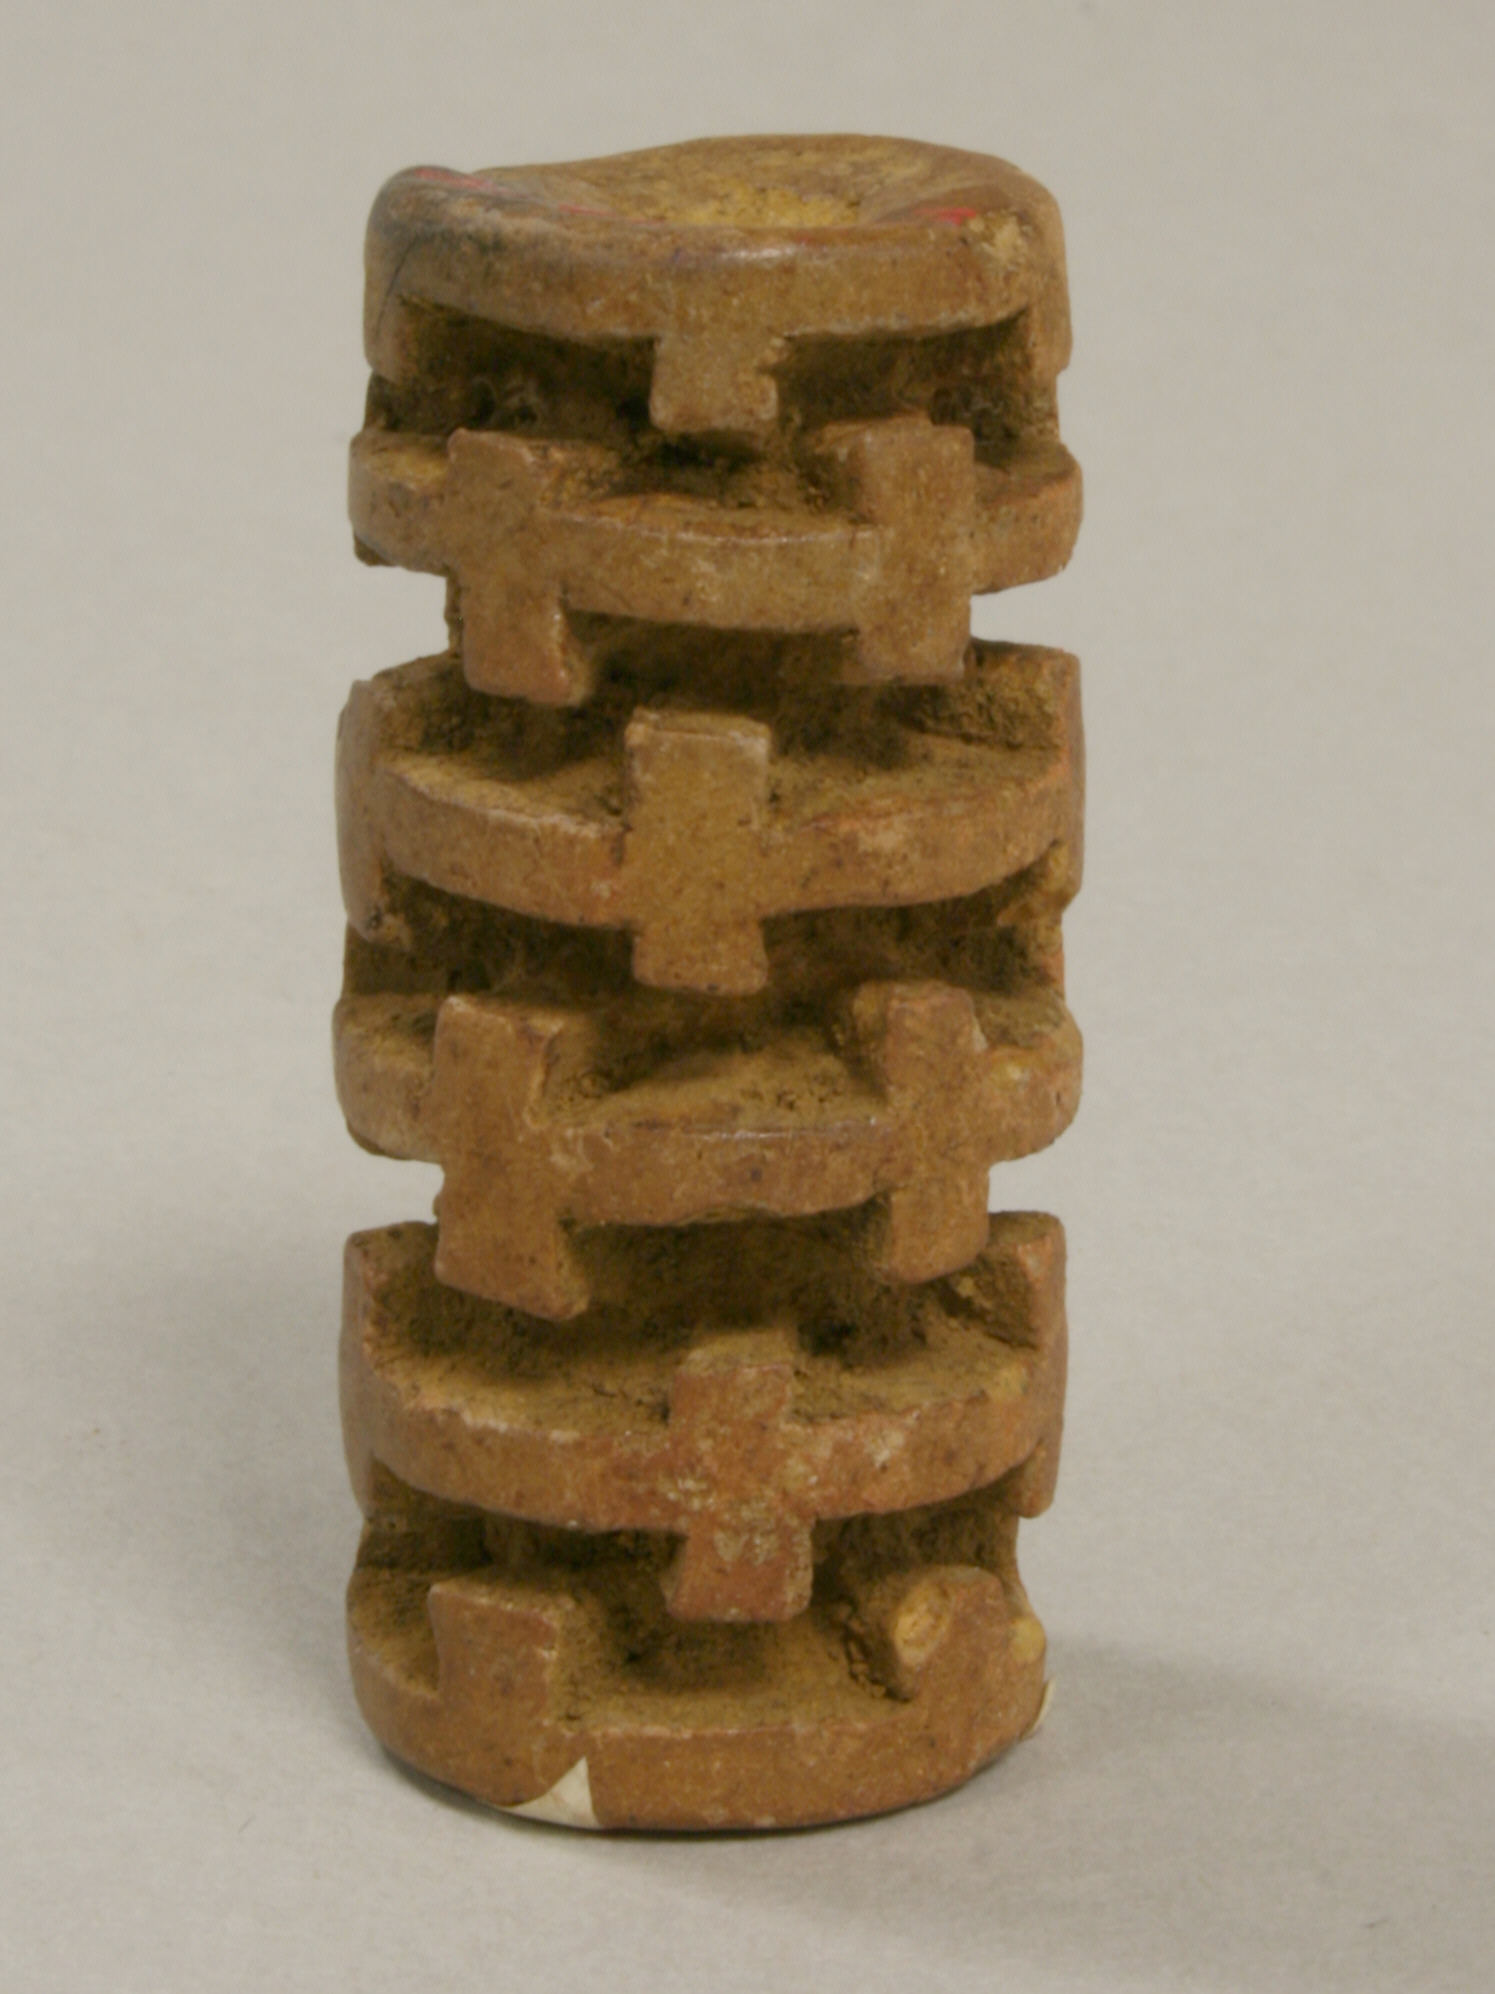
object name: stamp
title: Roller Stamp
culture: atlantic watershed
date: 401-600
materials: ceramic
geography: costa rica